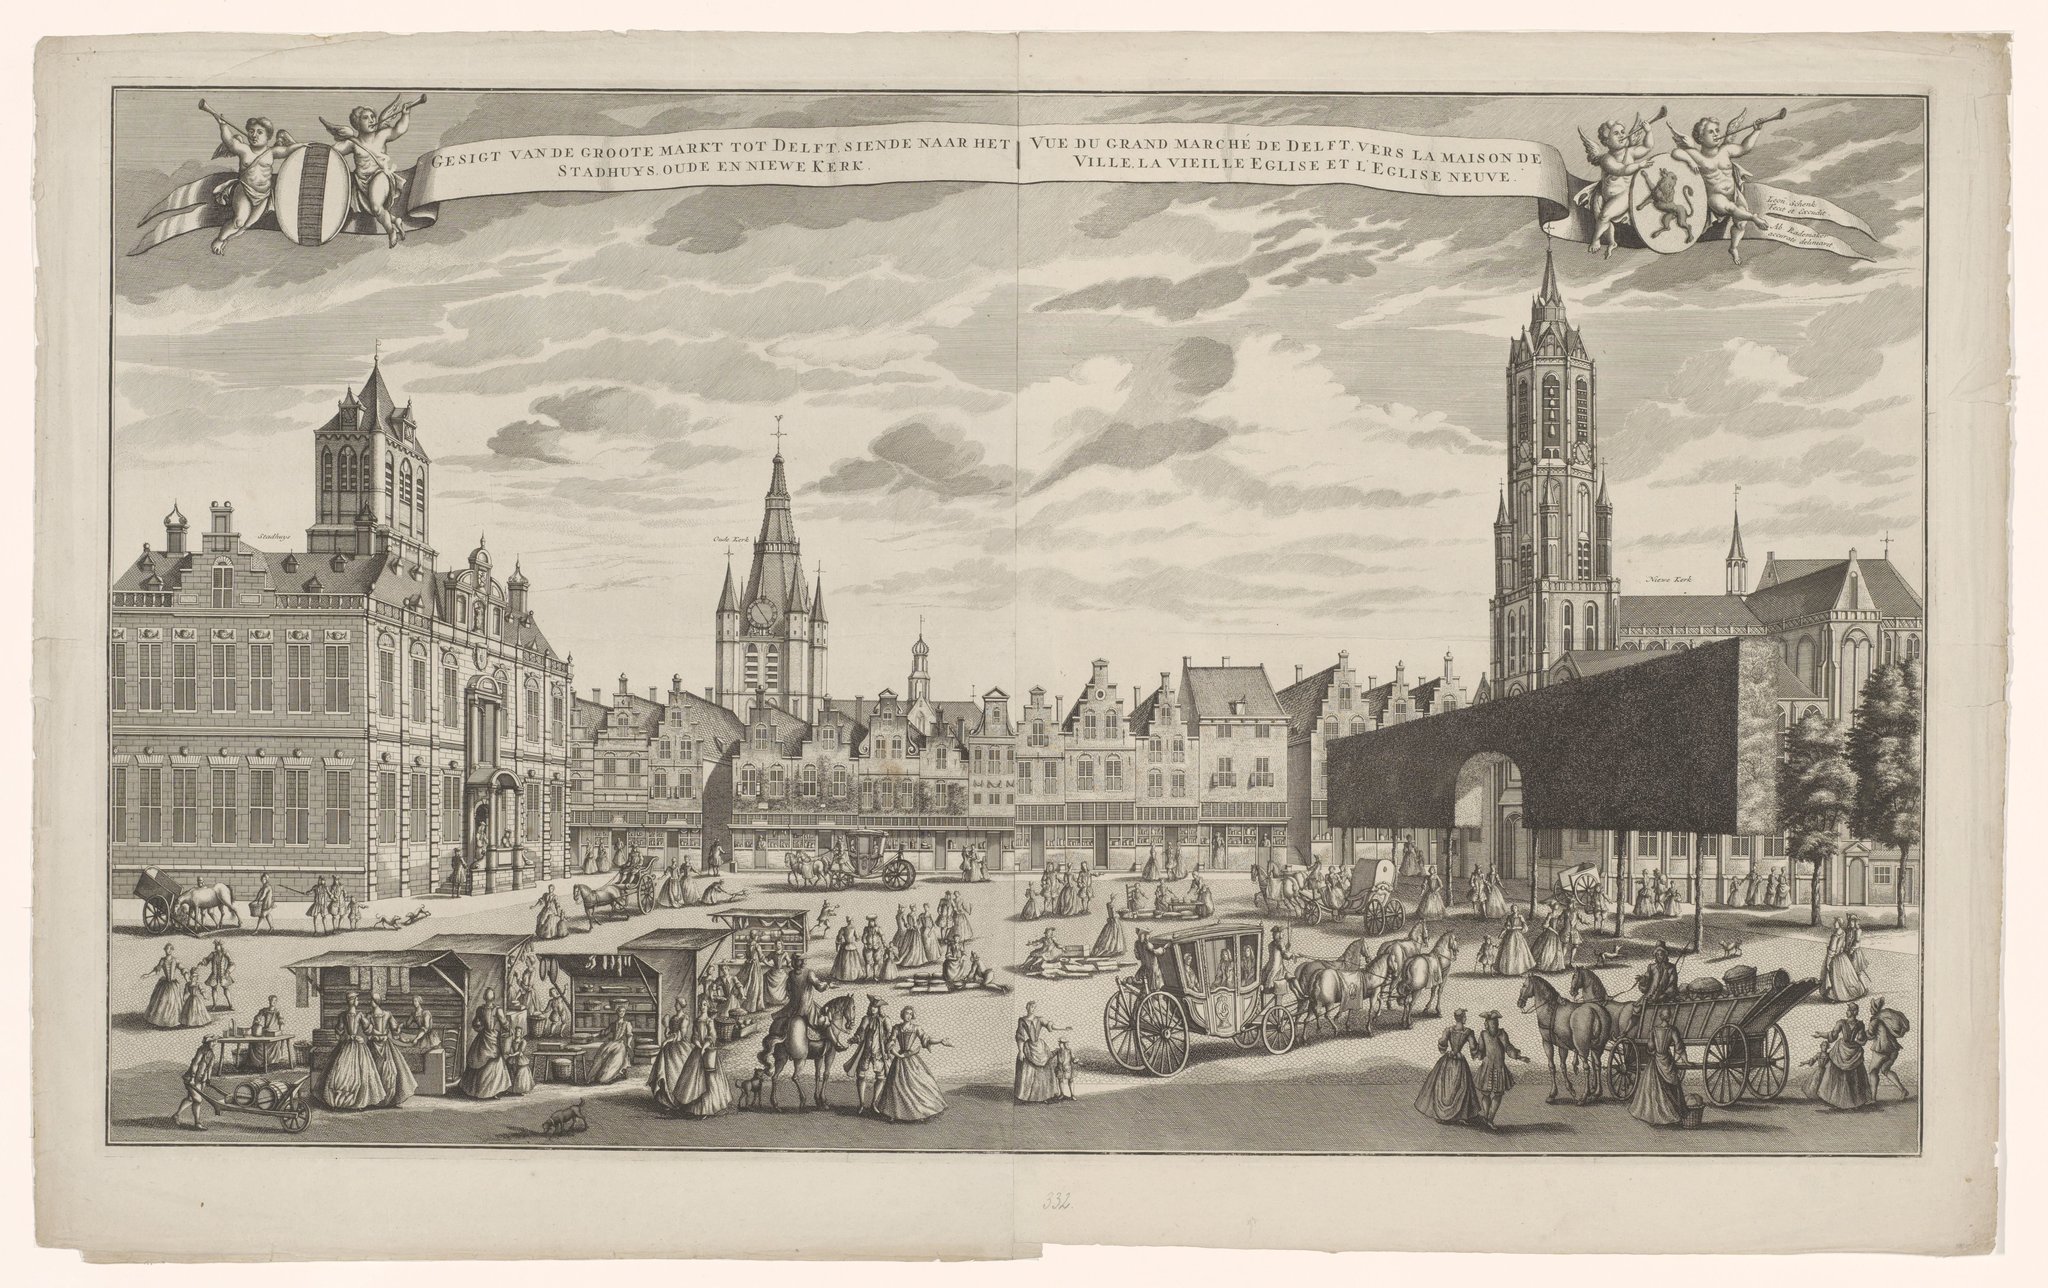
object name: print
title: Gezicht van de Groote Markt te Delft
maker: leonard schenk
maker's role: print maker, publisher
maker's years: 1696-1767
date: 1706-1767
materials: paper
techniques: etching